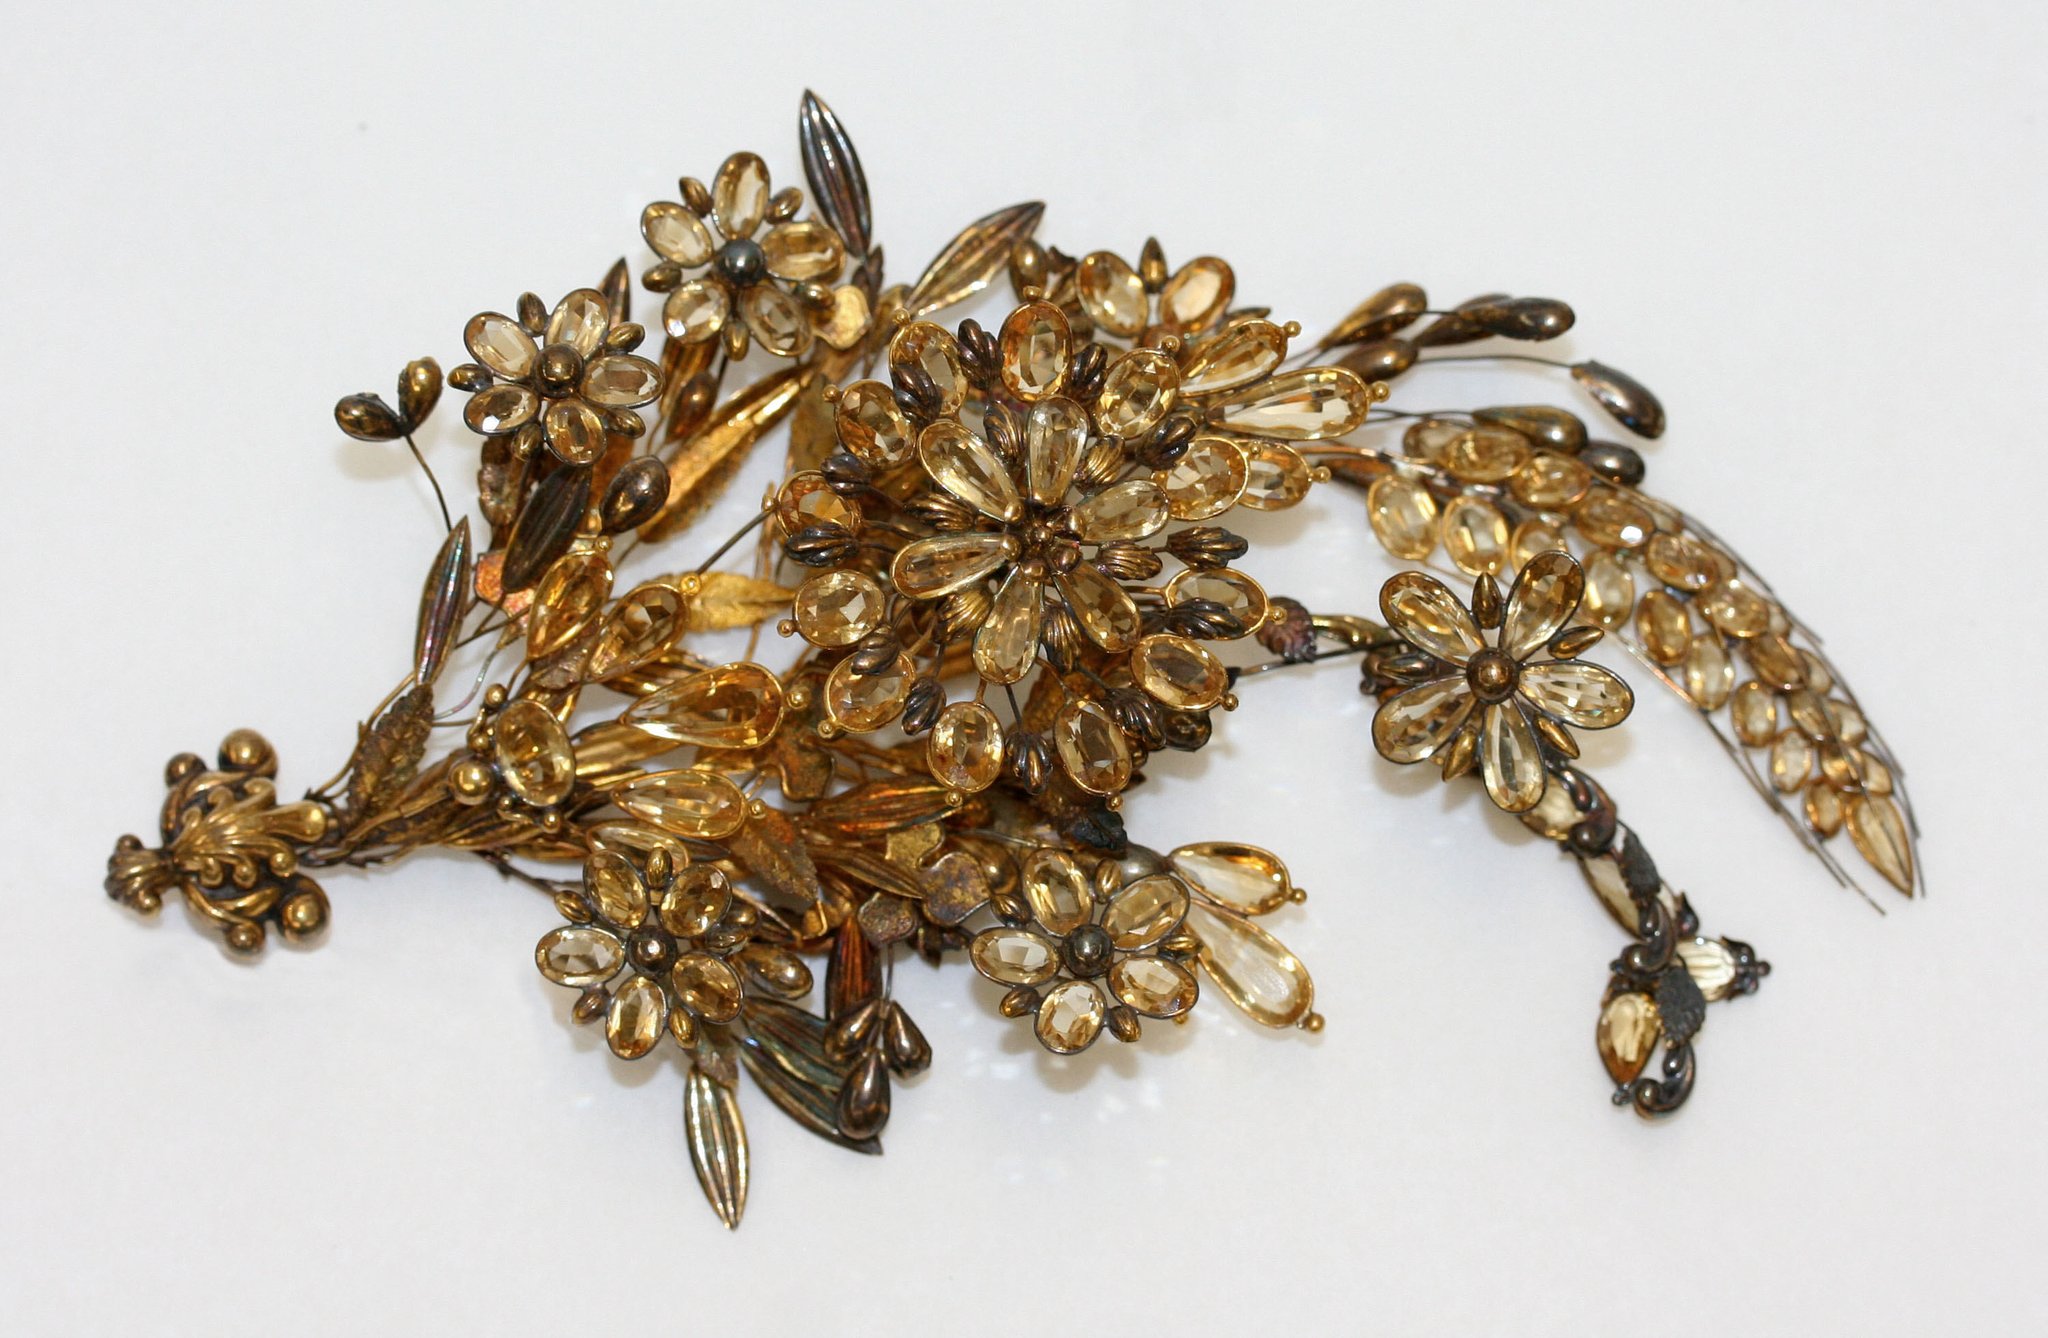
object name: hair accessory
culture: french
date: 1830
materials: silver gilt, gemstone